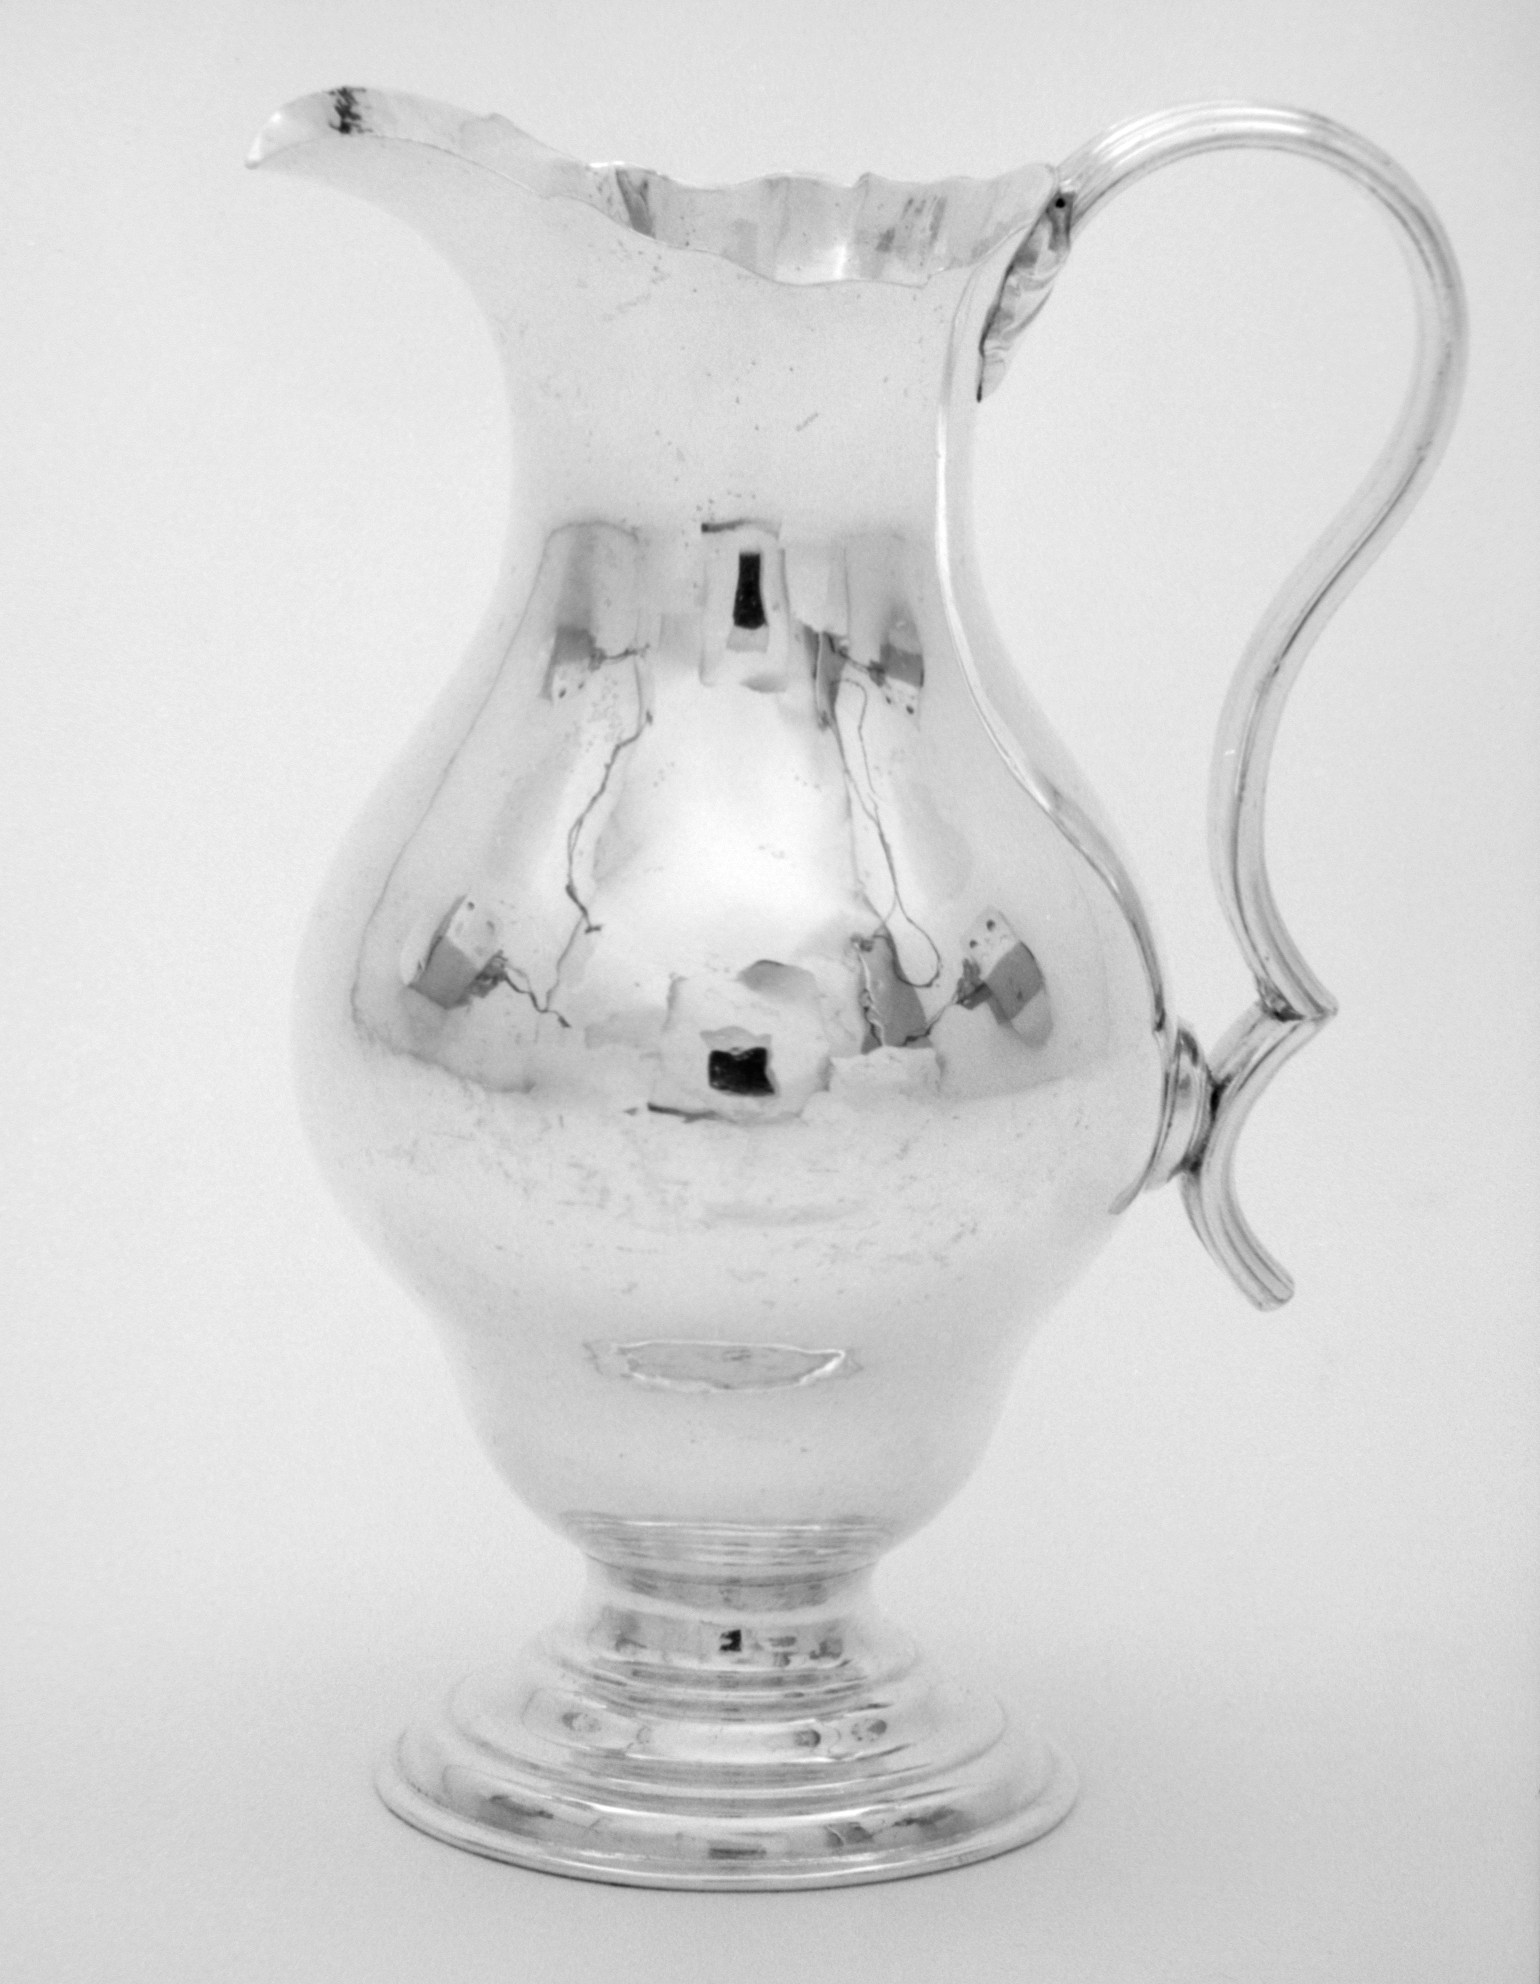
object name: cream jug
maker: tudor and leader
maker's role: maker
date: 1760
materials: metal